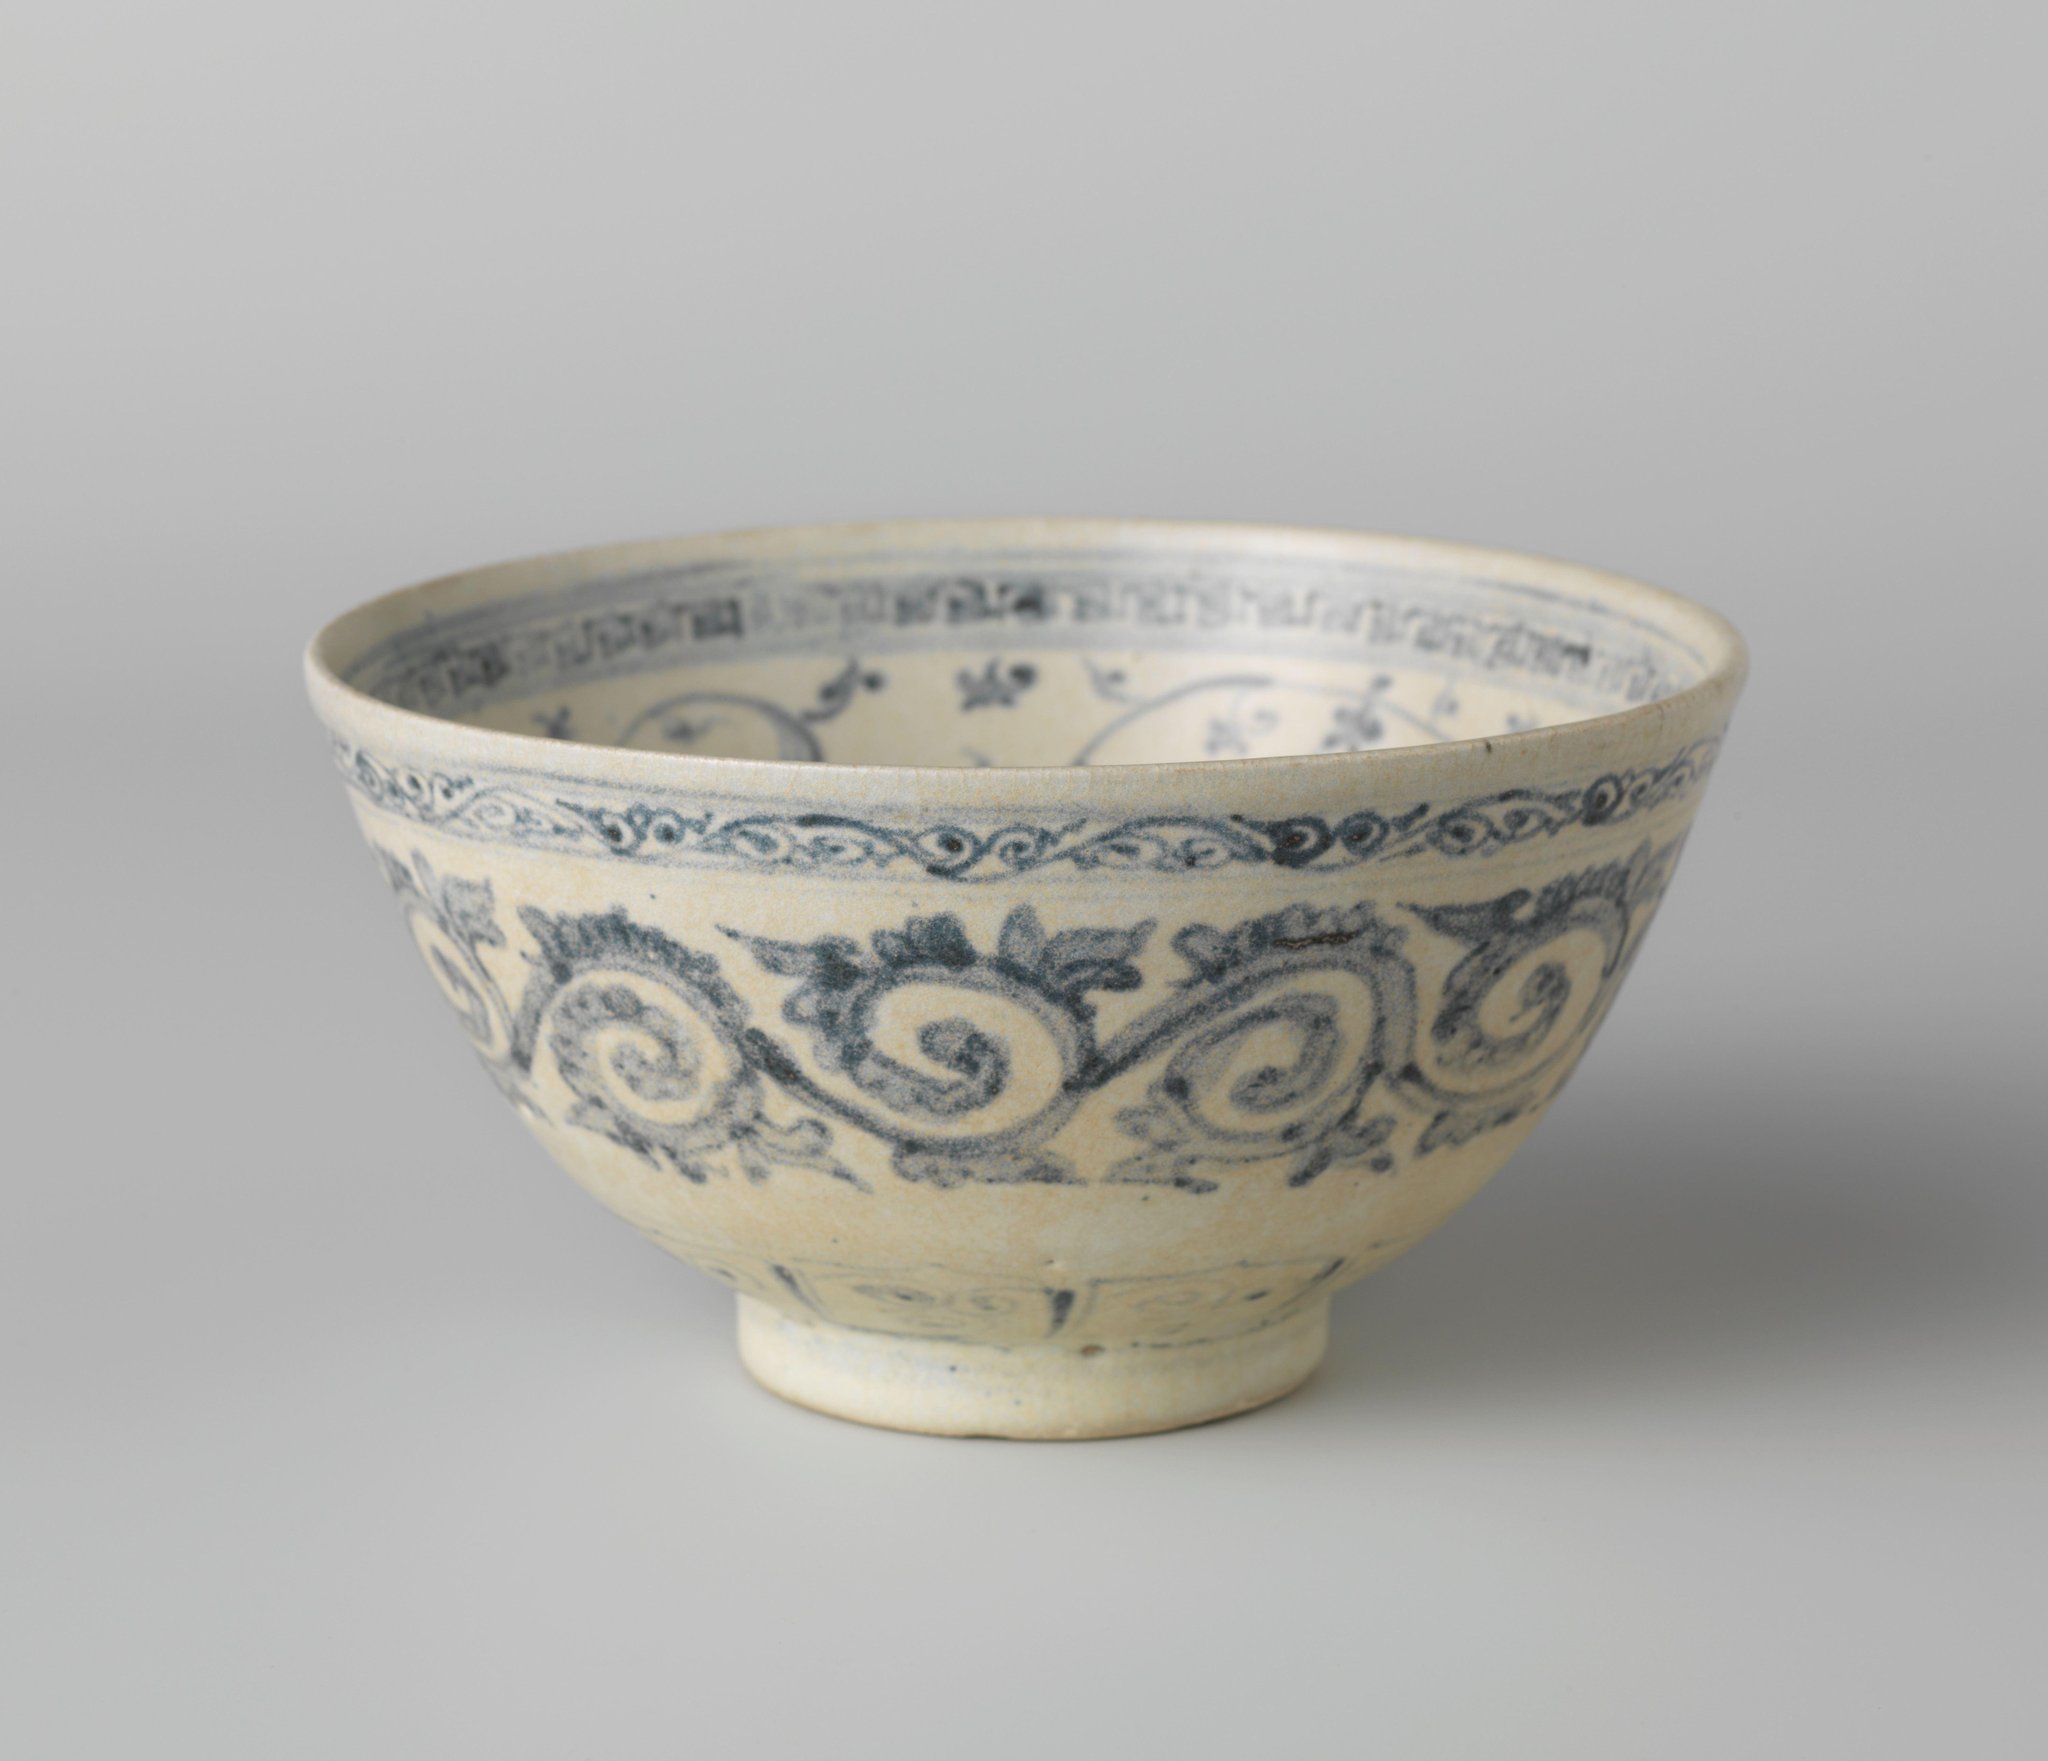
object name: bowl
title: Bell-shaped bowl with floral scrolls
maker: Anonymous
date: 1400-1499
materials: cobalt, glaze, paint, porcelain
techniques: firing, turning, vitrification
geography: vietnam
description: Klokvormige kom van porselein, beschilderd in onderglazuur blauw. Op de buitenwand een band met een doorlopende bladrank; rond de voet een band met bladmotieven. Op de buitenrand een band met krulwerk. De bodem met een gestileerde lotus in een dubbele cirkel. Op de binnenwand een doorlopende bloemrank en de binnenrand met een decoratieve band met meanderpatroon. Blauw-wit.